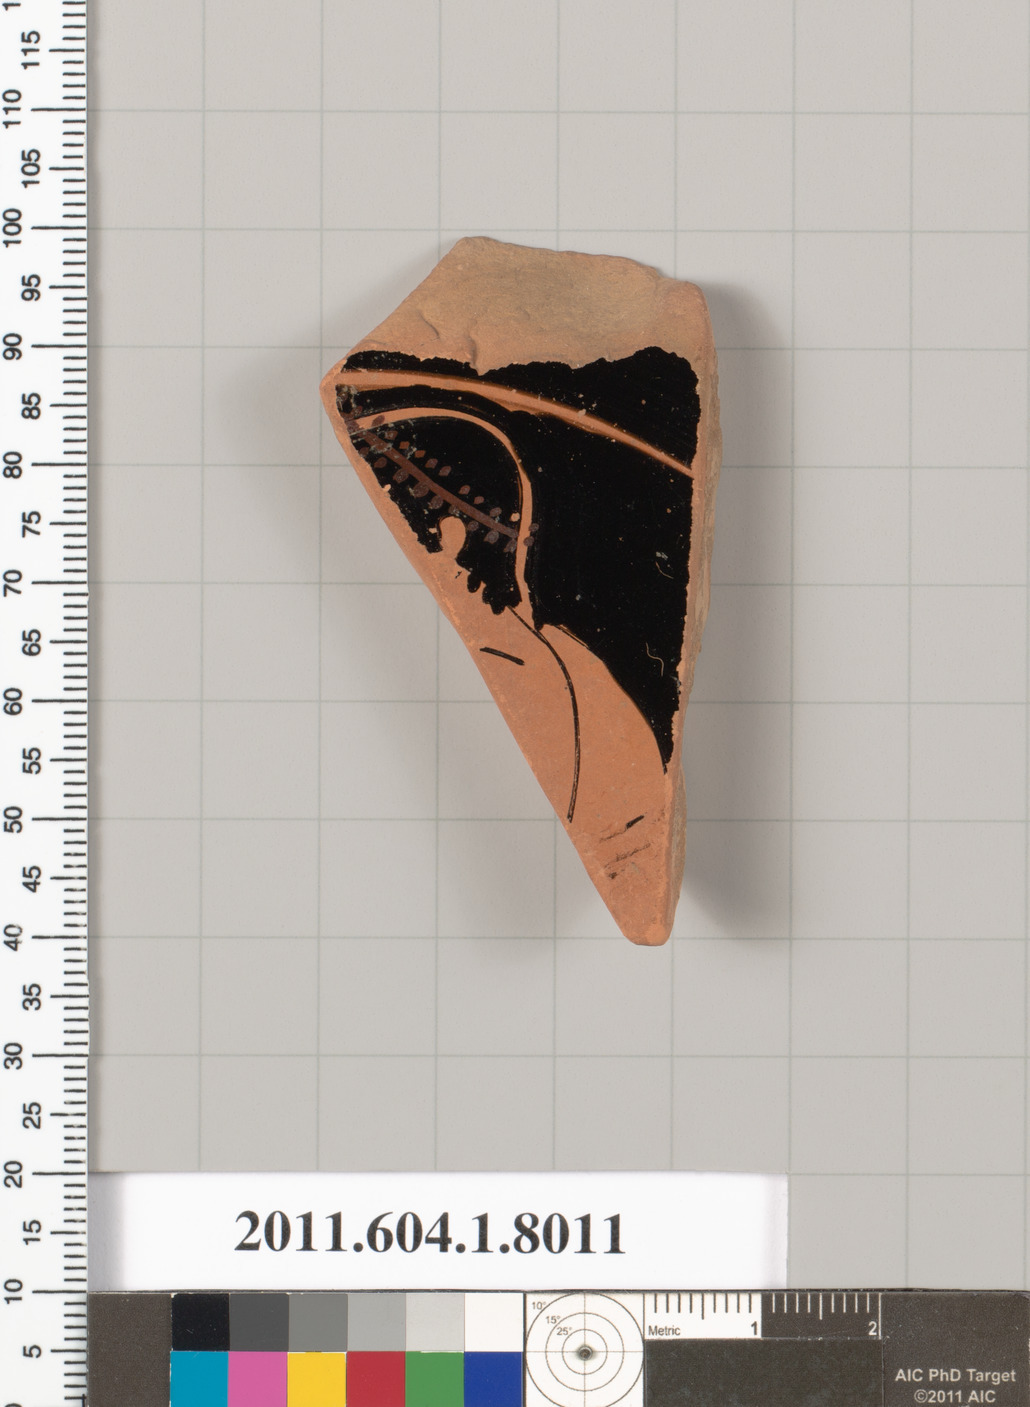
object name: kylix fragment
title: Terracotta fragment of a kylix (drinking cup)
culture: greek, attic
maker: euergides painter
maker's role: artist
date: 510-500 BCE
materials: terracotta